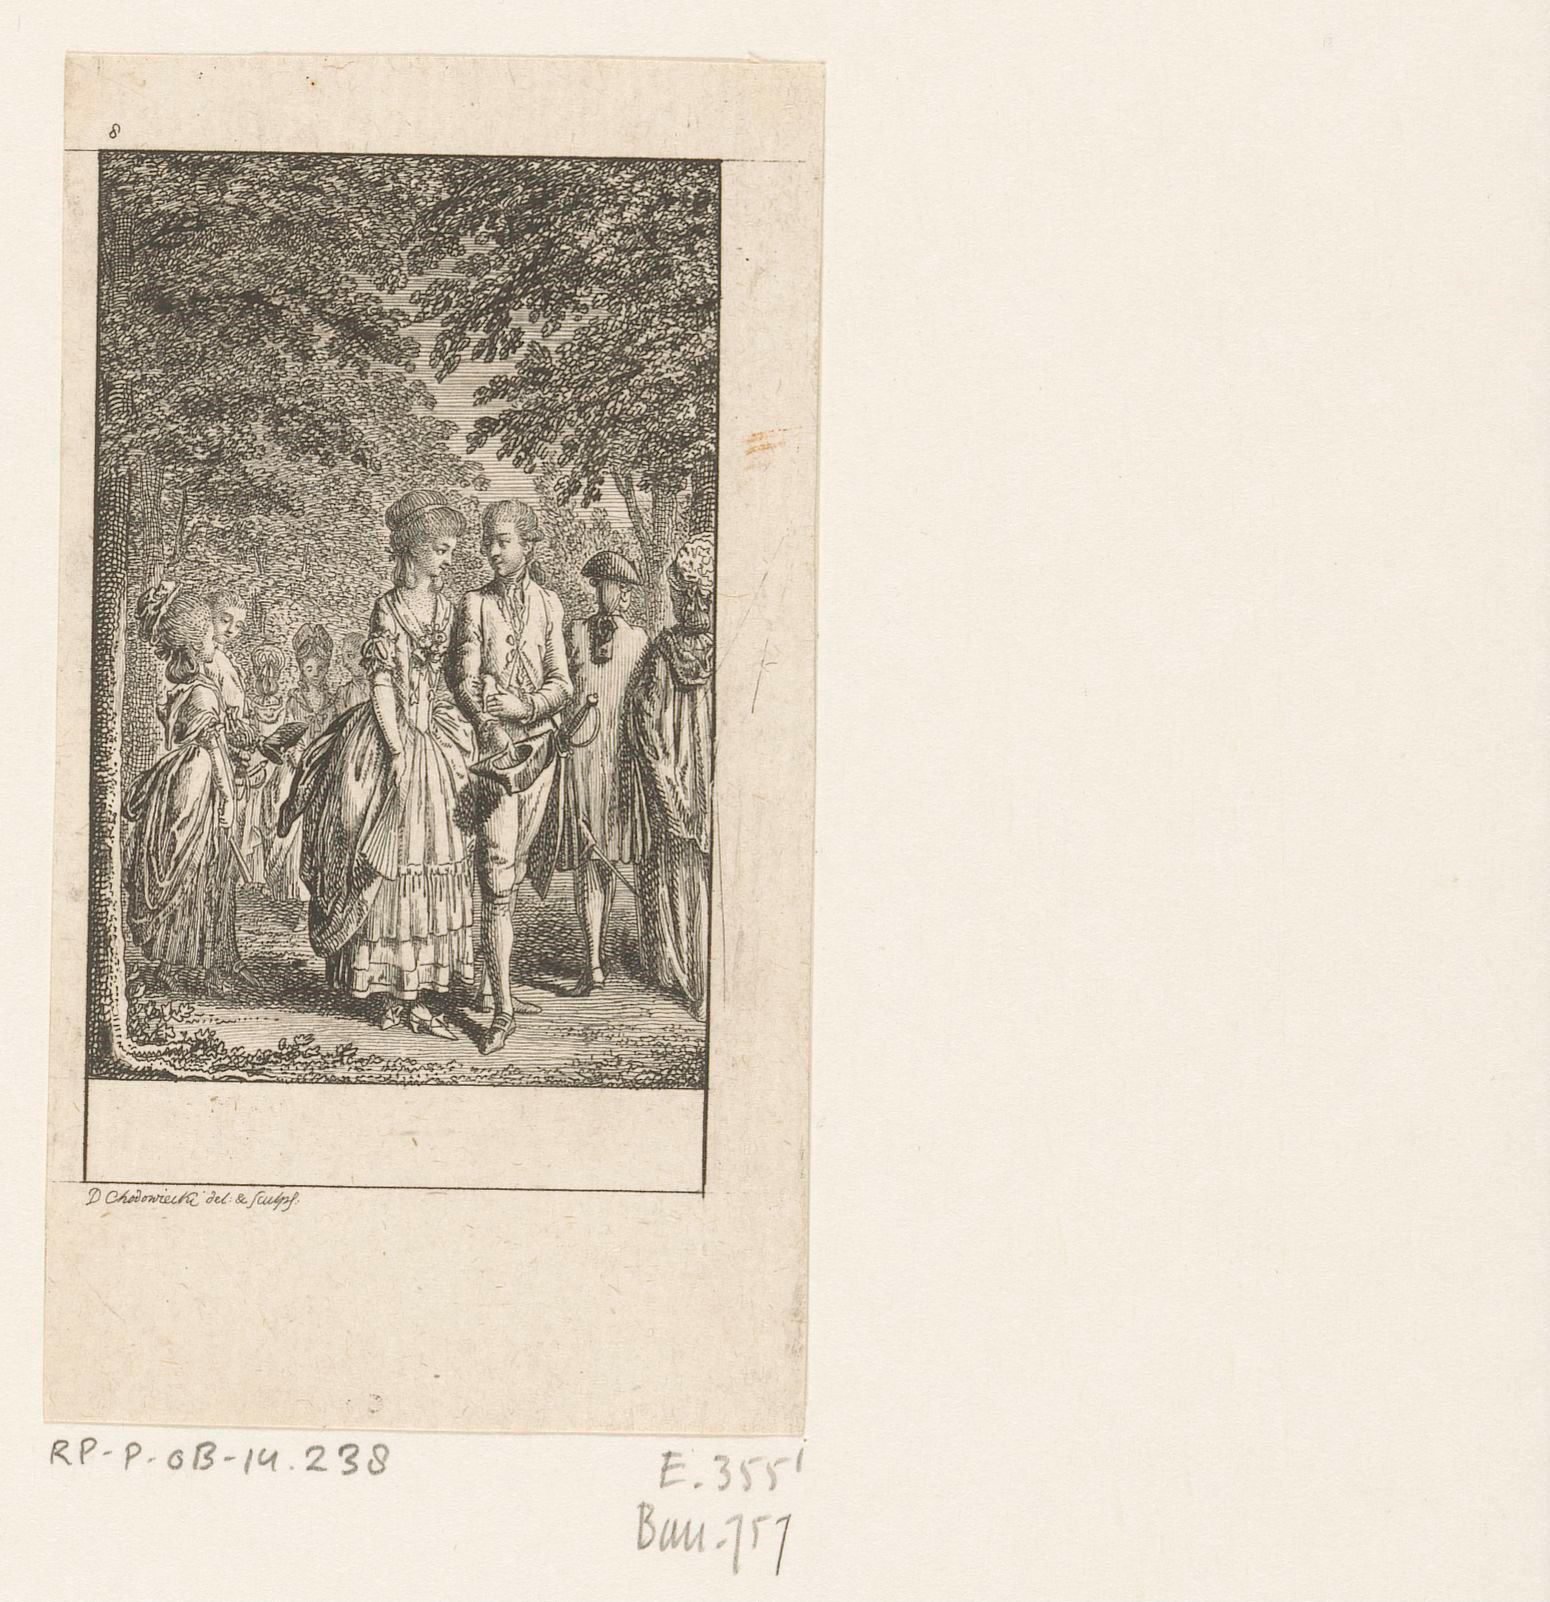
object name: print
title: Wandelende dames en heren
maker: daniel nikolaus chodowiecki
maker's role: draughtsman, print maker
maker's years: 1726-1801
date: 1780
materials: paper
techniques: etching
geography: berlin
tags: forest, wood, walking arm in arm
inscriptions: collector's mark: Lugt 2228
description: Prent gebruikt voor: Almanac Généalogique pour l'année 1781 (...). S.l.s.n., [1780]. Een serie van twaalf prenten betreffende bezigheden voor dames.